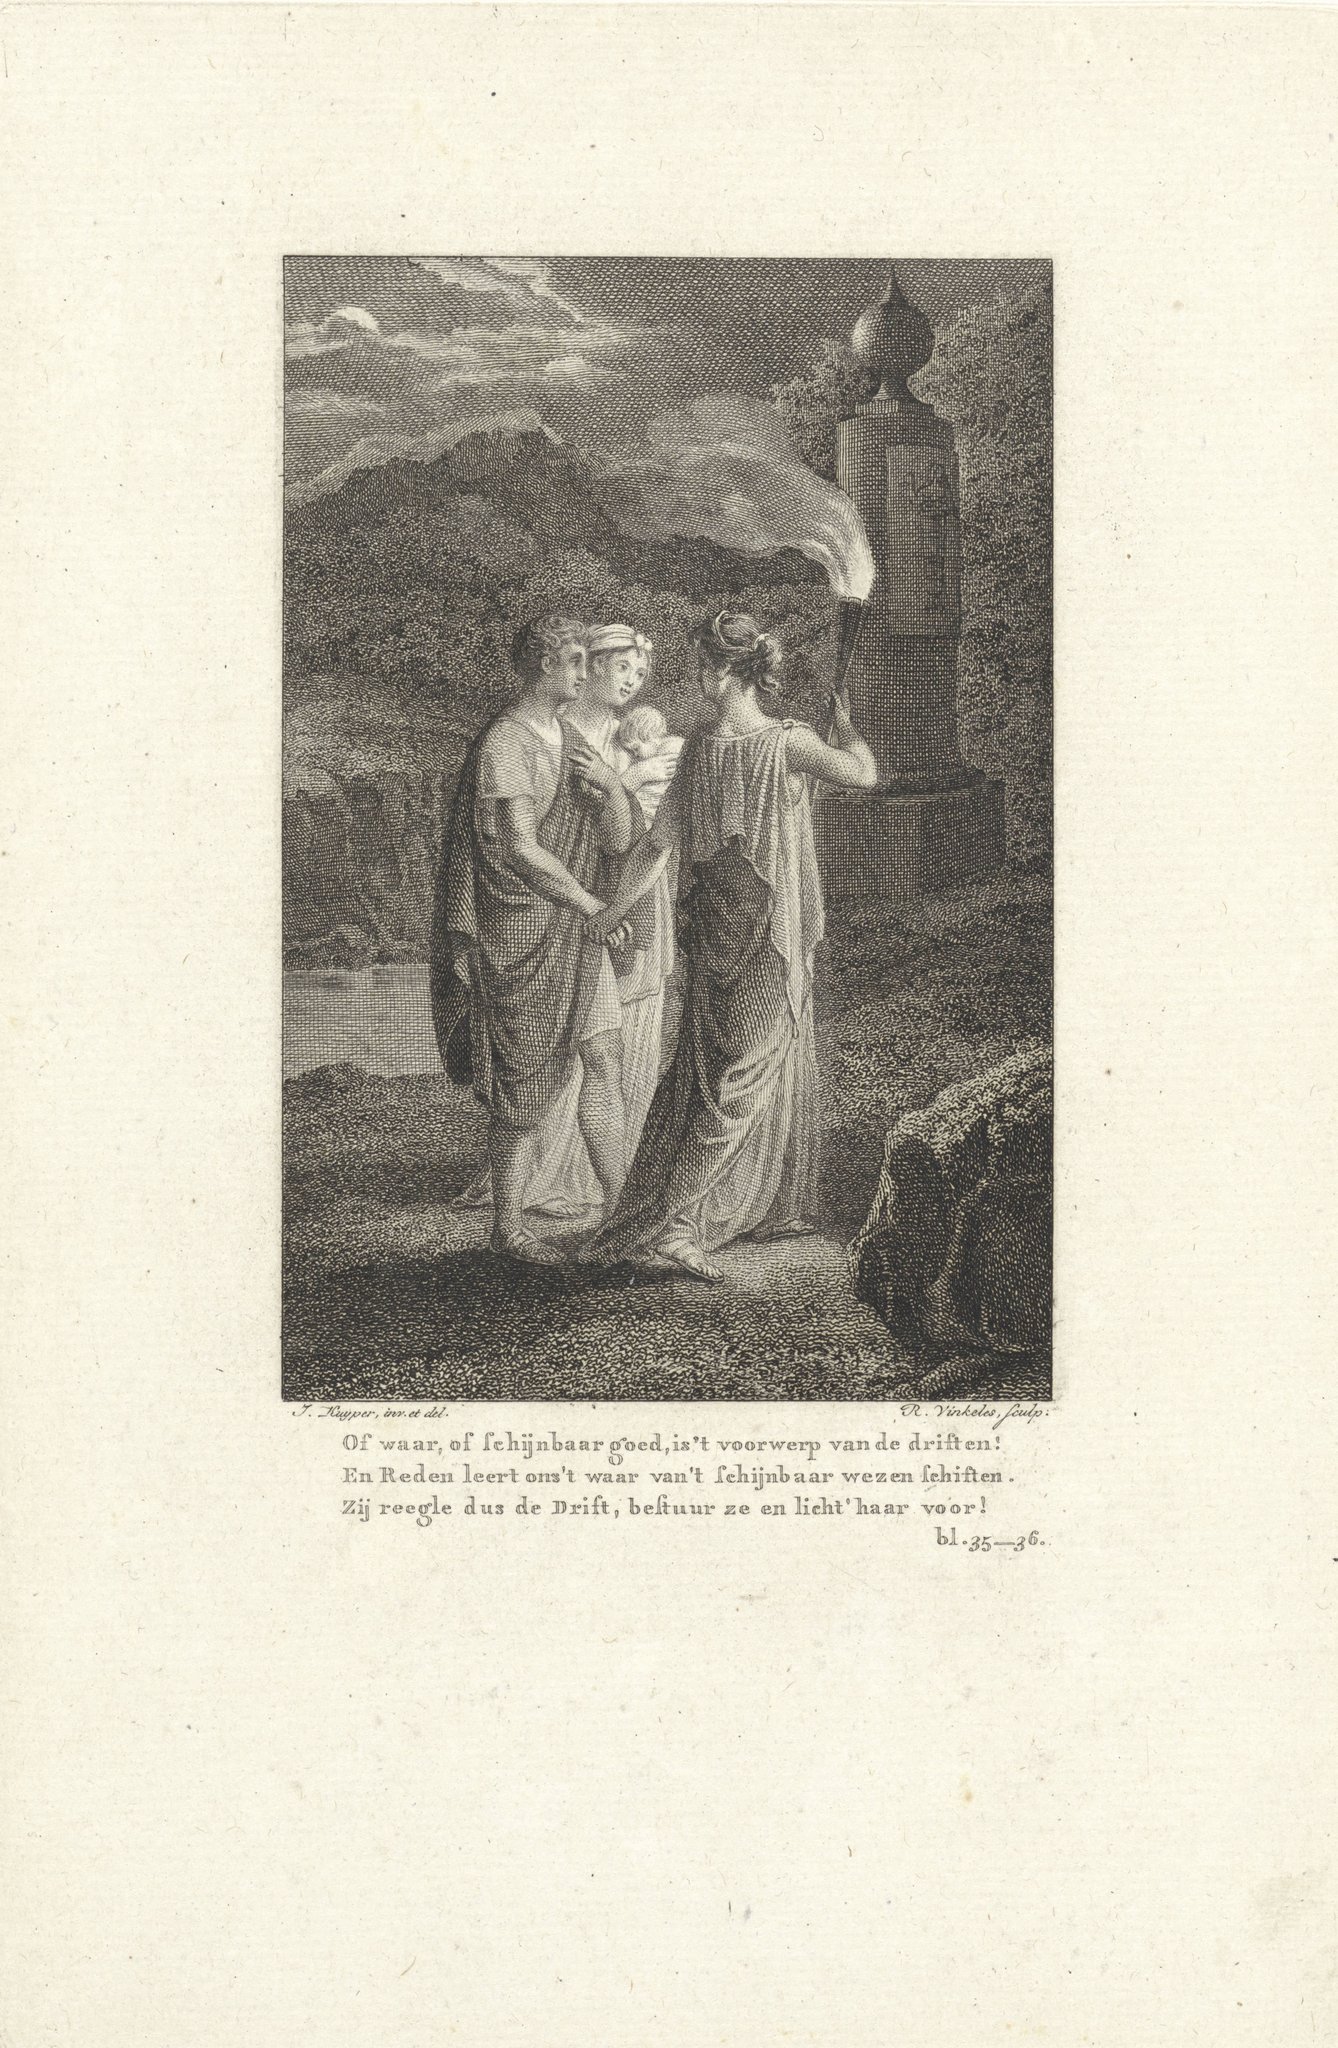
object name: print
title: Nachtgezicht met drie figuren met een baby in een landschap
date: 1807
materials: paper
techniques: engraving, etching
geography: amsterdam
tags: torch, night ~ landscape (sometimes titled 'nox'), infant, baby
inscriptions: collector's mark: Lugt 2228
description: Deze prent is ook gebruikt als illustratie voor: Bilderdijk, Willem. De Mensch: Popes Essay on men. Amsterdam: Johannes Allart, 1807, p. 35-36.